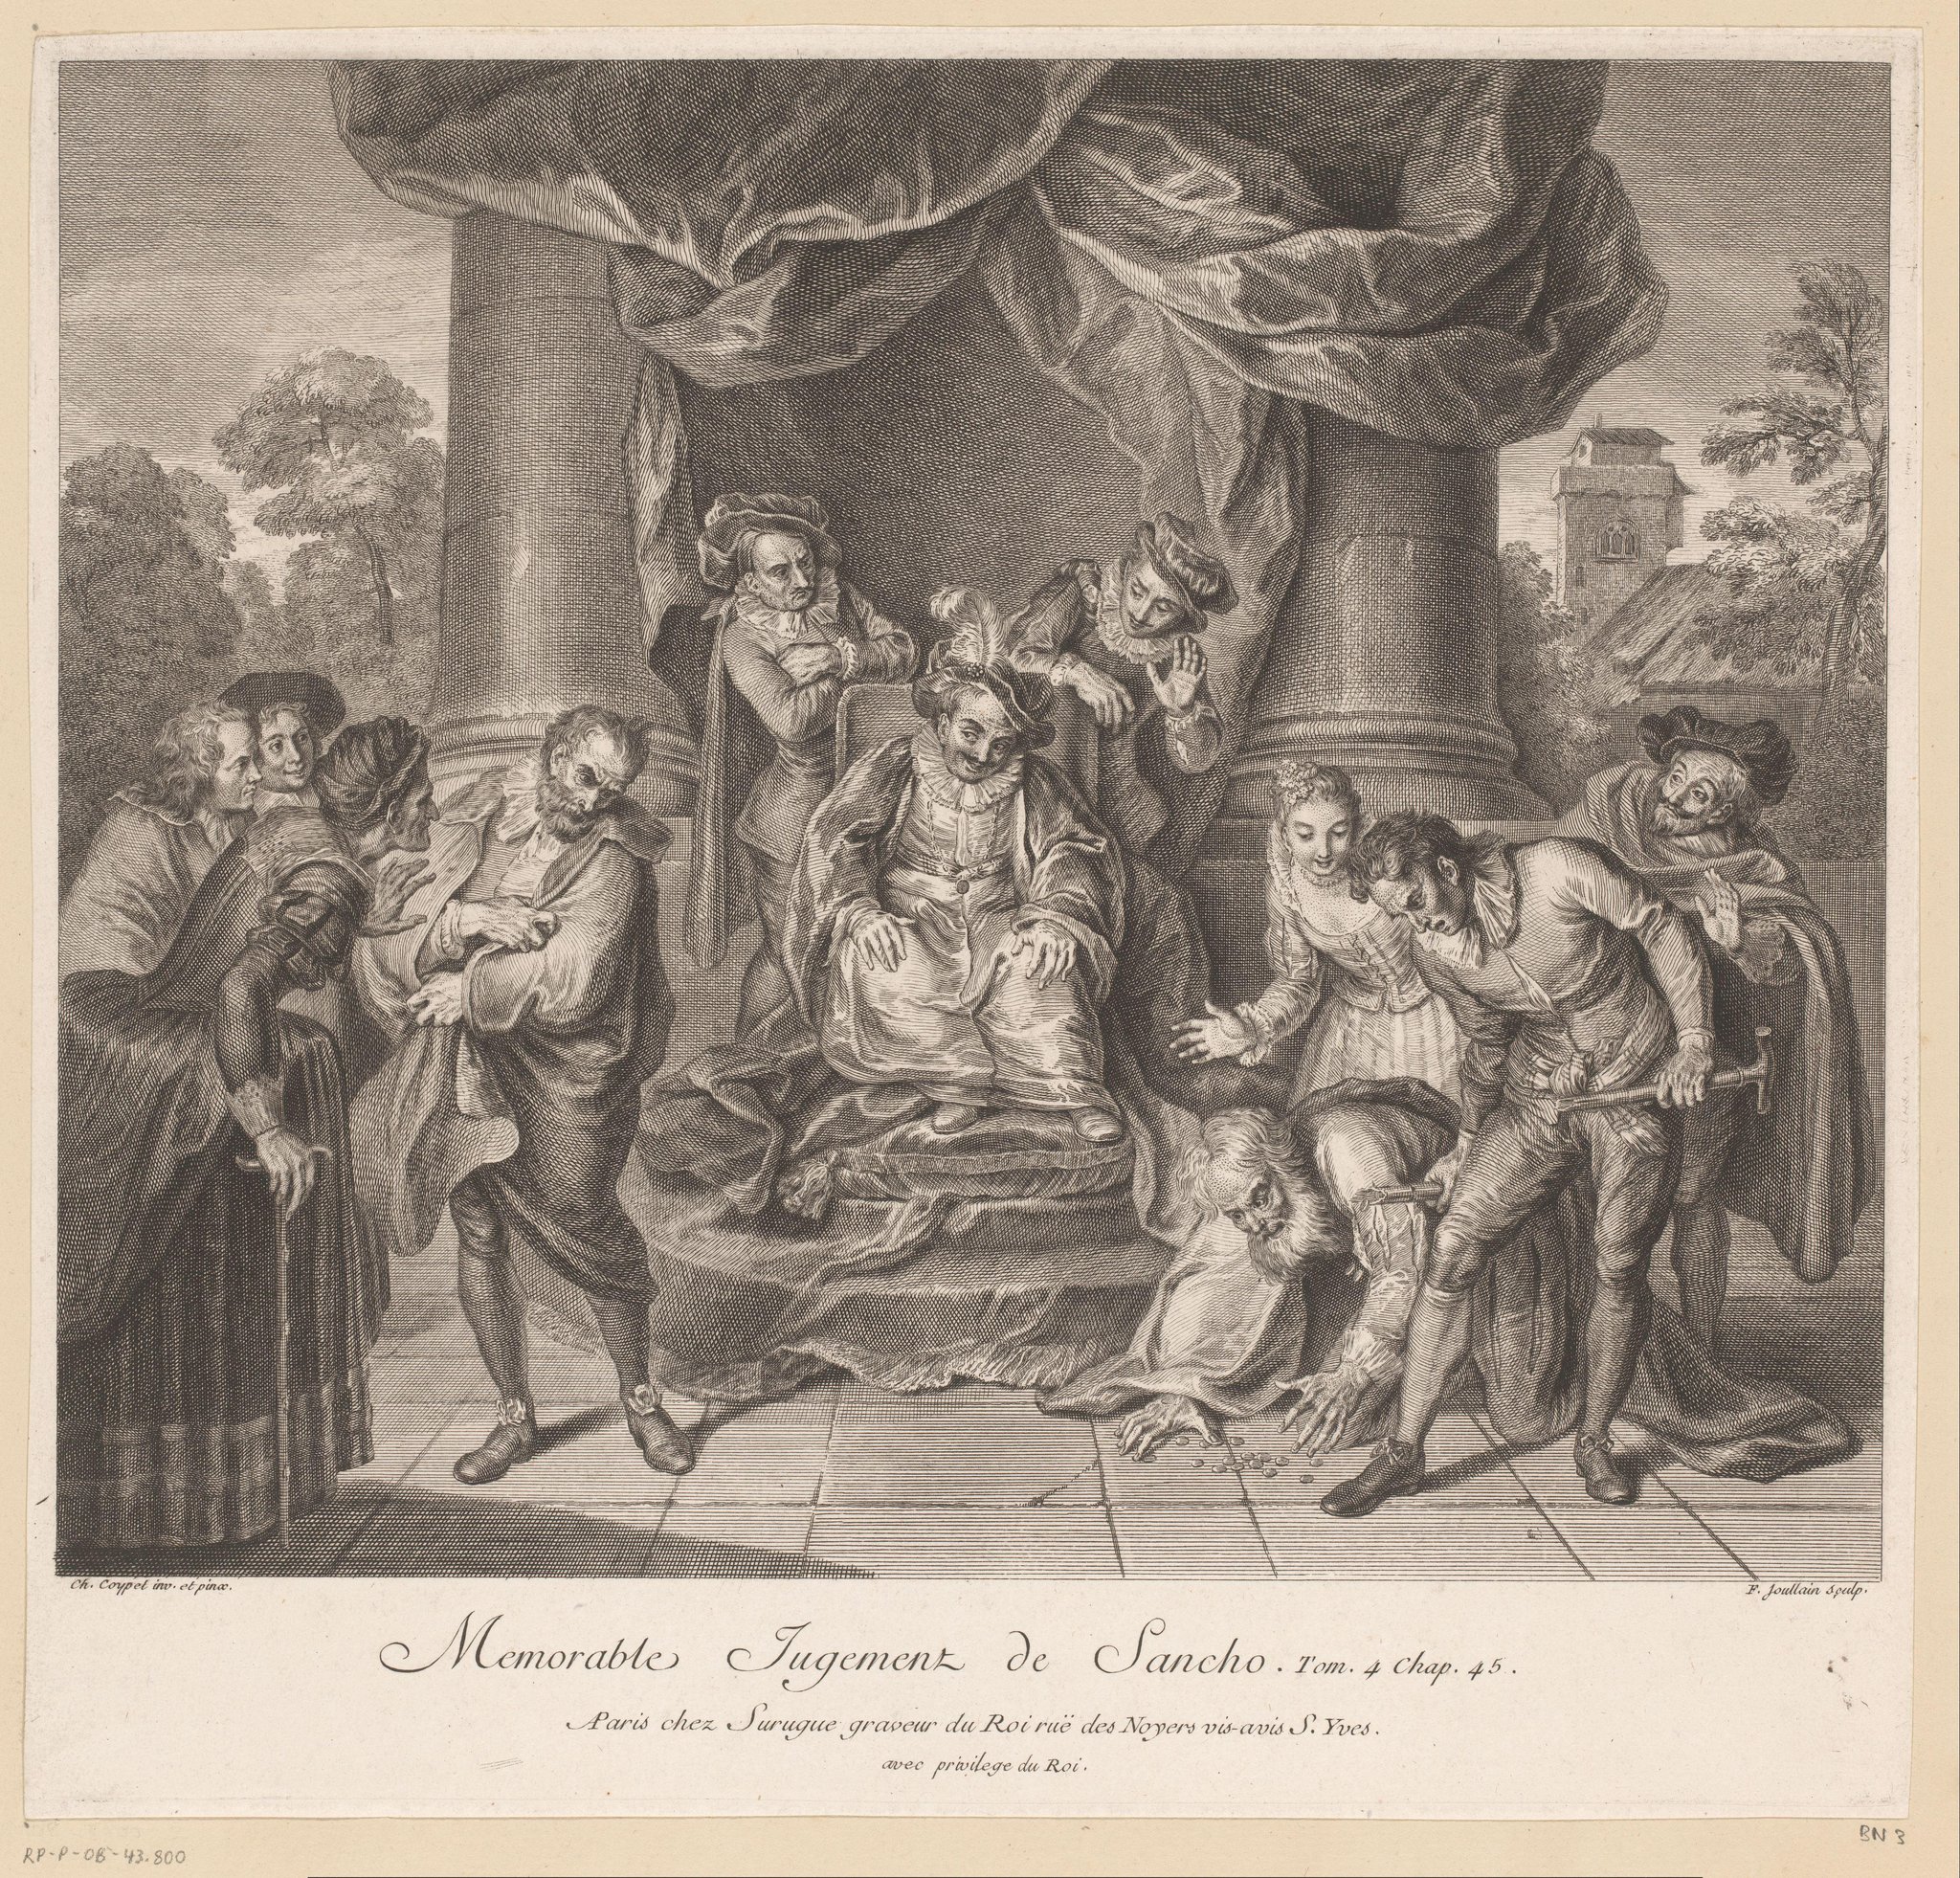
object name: print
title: Memorable Jugement de Sanco.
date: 1723-1724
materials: paper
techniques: engraving, etching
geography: paris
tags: judgement, discrimination; 'giuditio' (ripa), sancho panza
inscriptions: collector's mark: Lugt 240